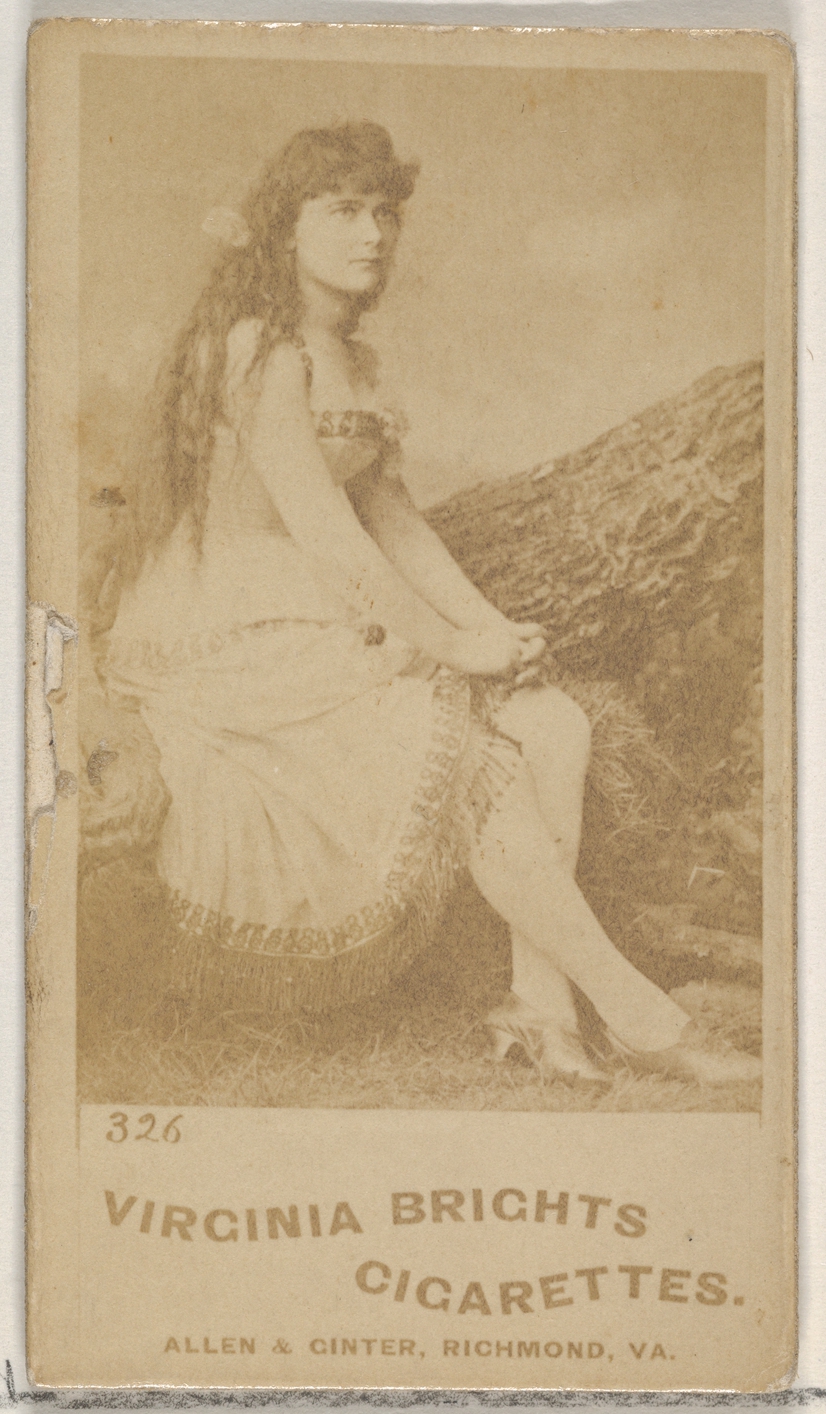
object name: photograph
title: Card 326, from the Actors and Actresses series (N45, Type 5) for Virginia Brights Cigarettes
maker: allen & ginter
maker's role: publisher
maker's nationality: american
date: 1888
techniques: albumen silver print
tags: portraits,women,actresses